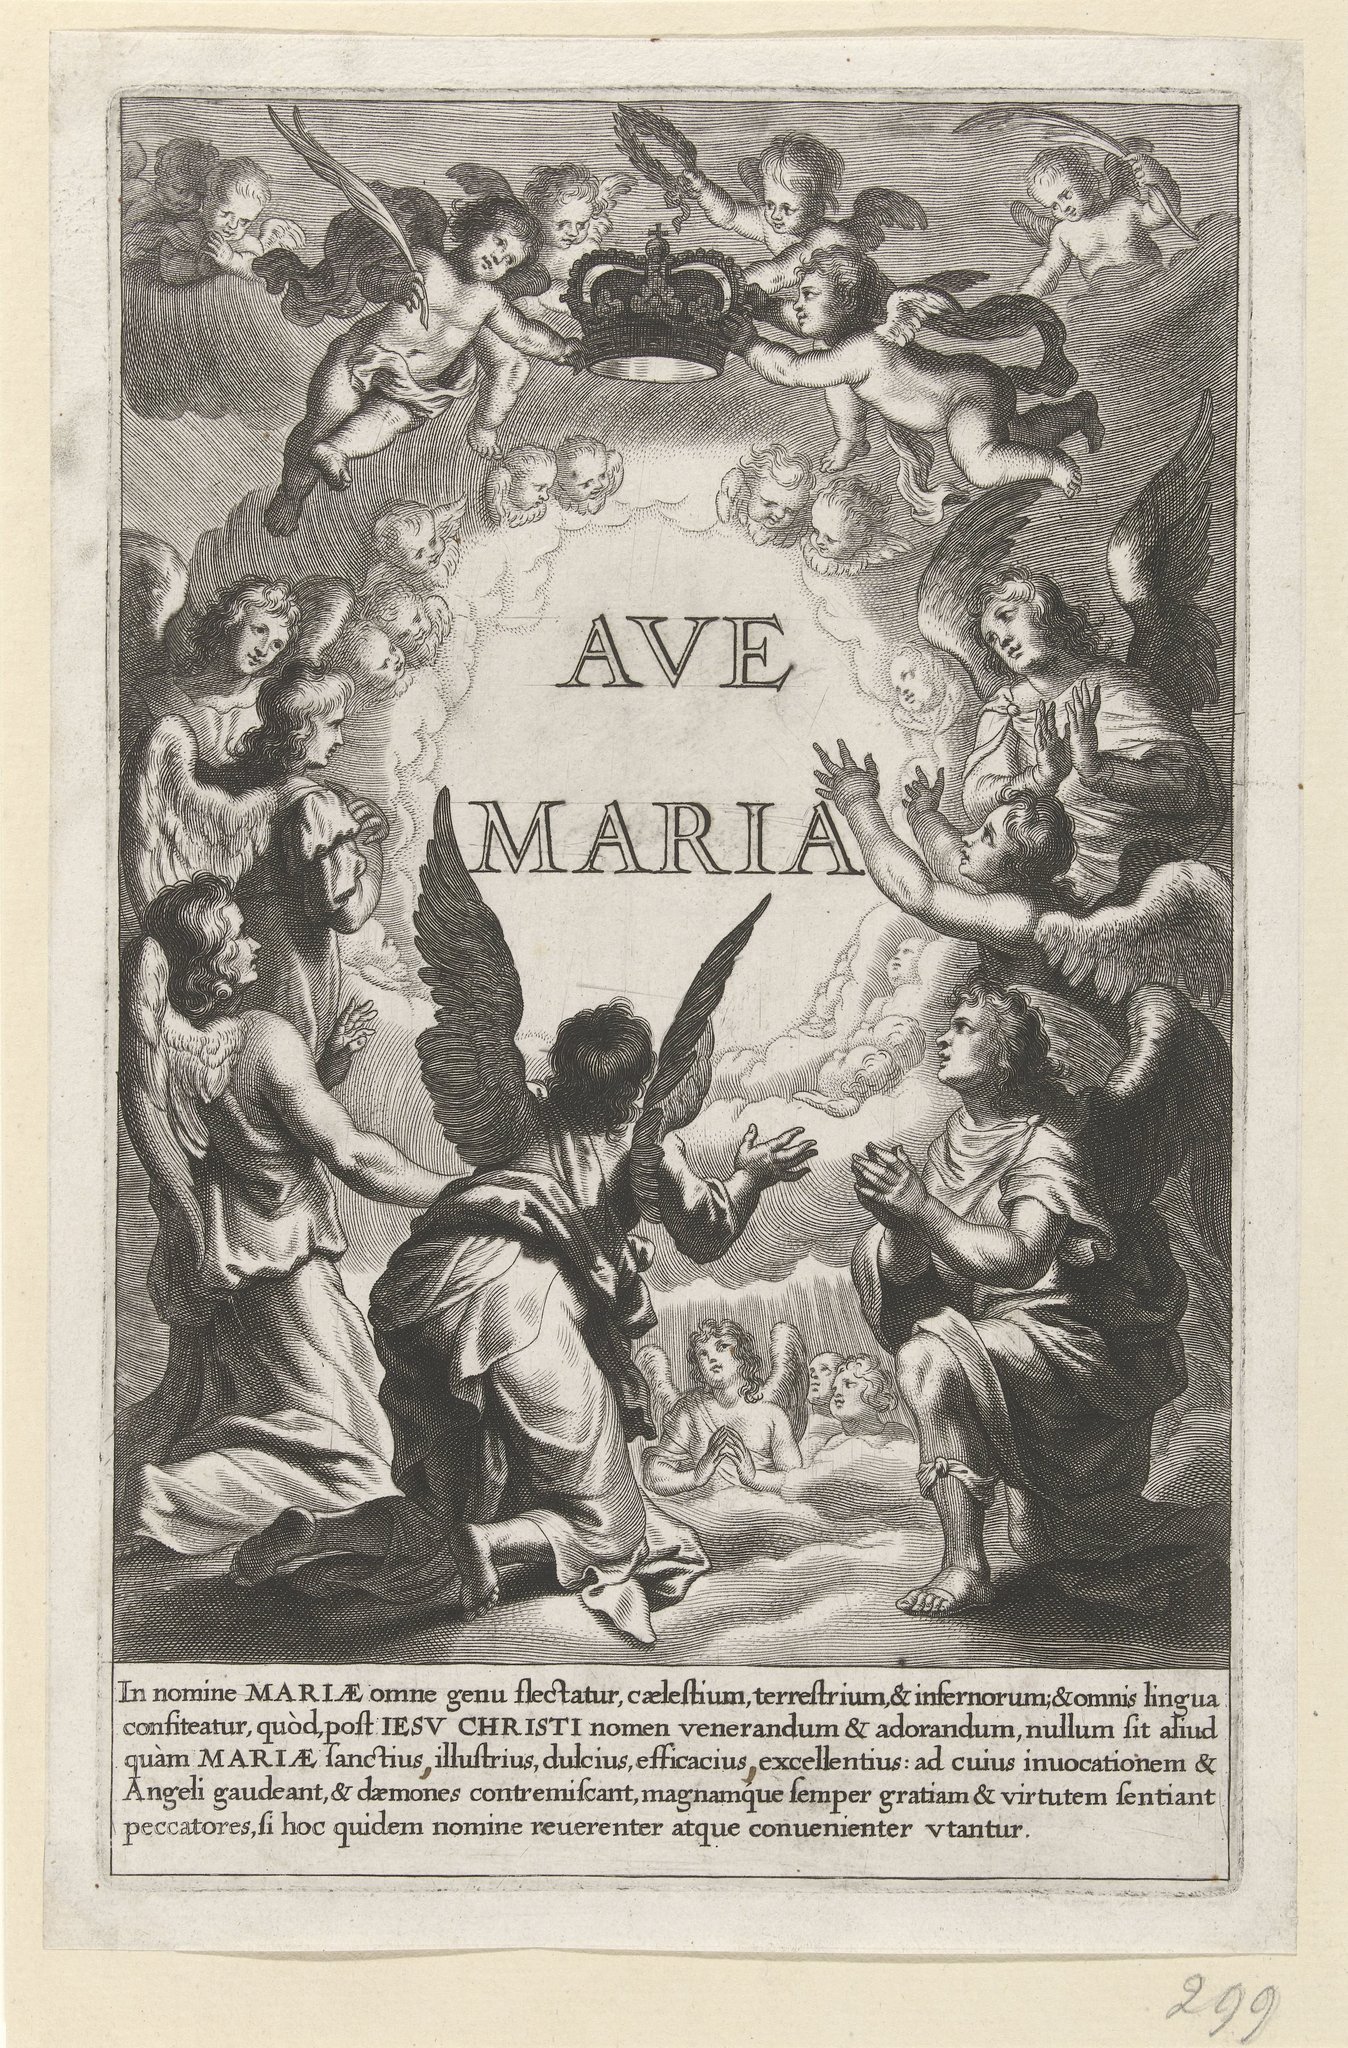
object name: print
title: Groep engelen staat klaar voor de kroning van Maria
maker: cornelis galle (i)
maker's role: print maker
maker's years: 1576-1650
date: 1586-1650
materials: paper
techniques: engraving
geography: southern netherlands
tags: coronation of mary by one or more angels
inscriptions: collector's mark: Lugt 240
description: Titelprent voor een serie die waarschijnlijk bestaat uit vier prenten met verschillende voorstellingen van de staande Maria omgeven door engelen. Een groep engelen heeft zich verzameld om Maria te kronen. De engelen houden een kroon, een palmtak en een lauwerkrans vast. Onder de voorstelling een Latijnse tekst over Maria.